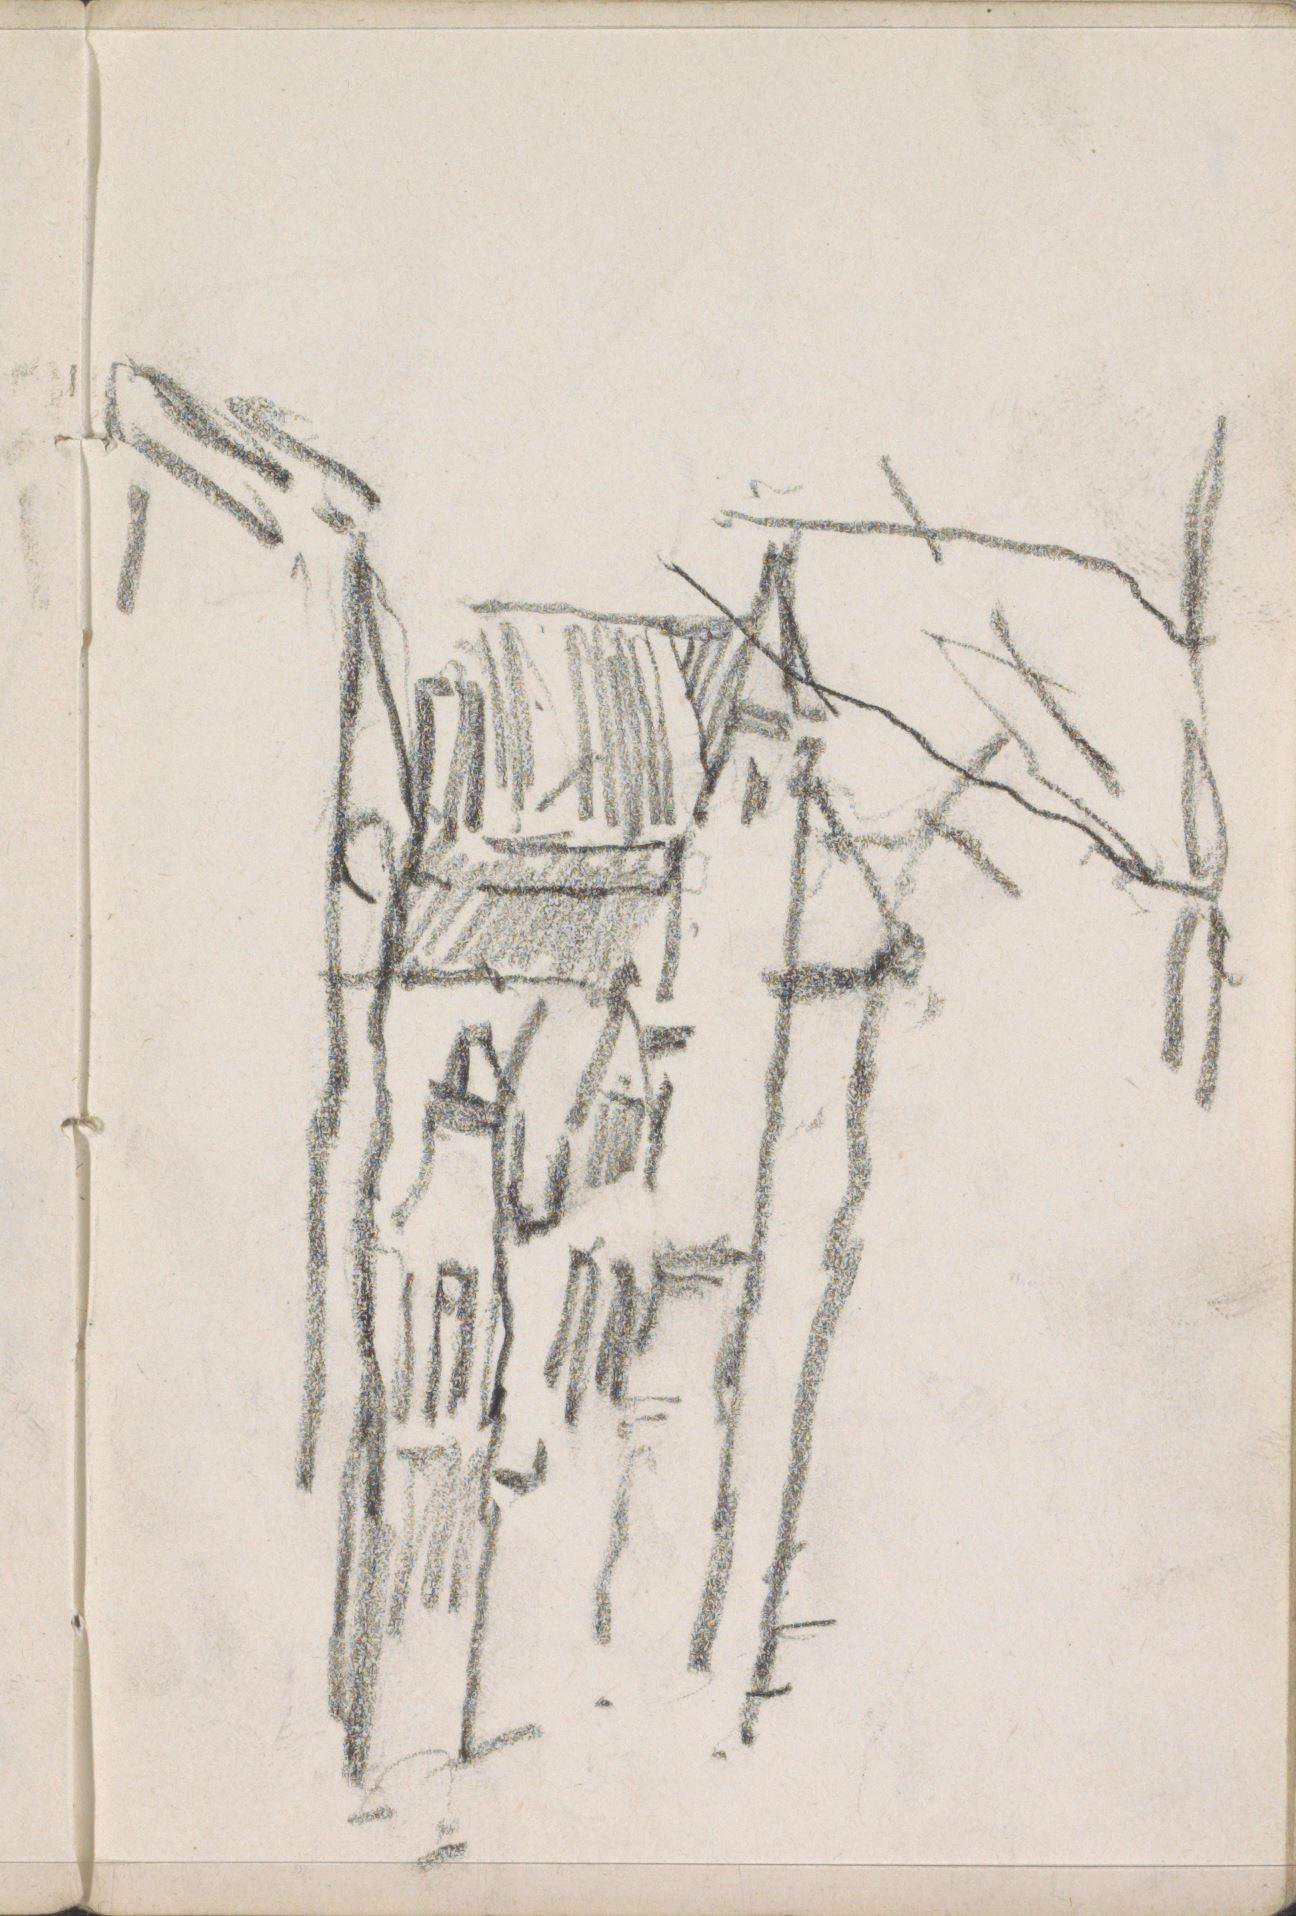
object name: sketchbook leaf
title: Gezicht in Amsterdam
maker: george hendrik breitner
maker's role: draughtsman, painter, print maker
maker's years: 1857-1923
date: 1917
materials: chalk, paper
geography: amsterdam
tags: civic architecture; edifices; dwellings, street, amsterdam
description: Pagina 20 uit een schetsboek met 44 bladen.